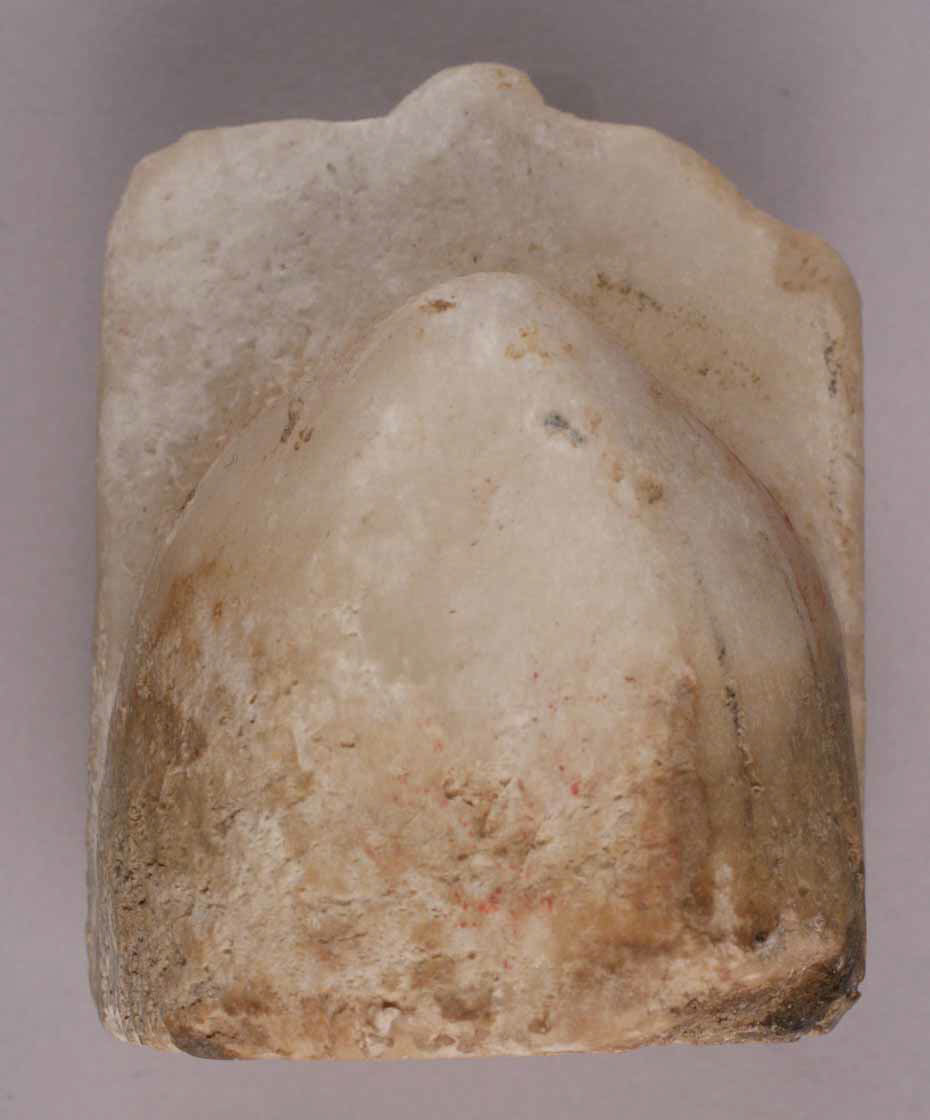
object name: chess piece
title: Chess Piece, King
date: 801-1200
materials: alabaster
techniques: carving, painting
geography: iran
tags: chess